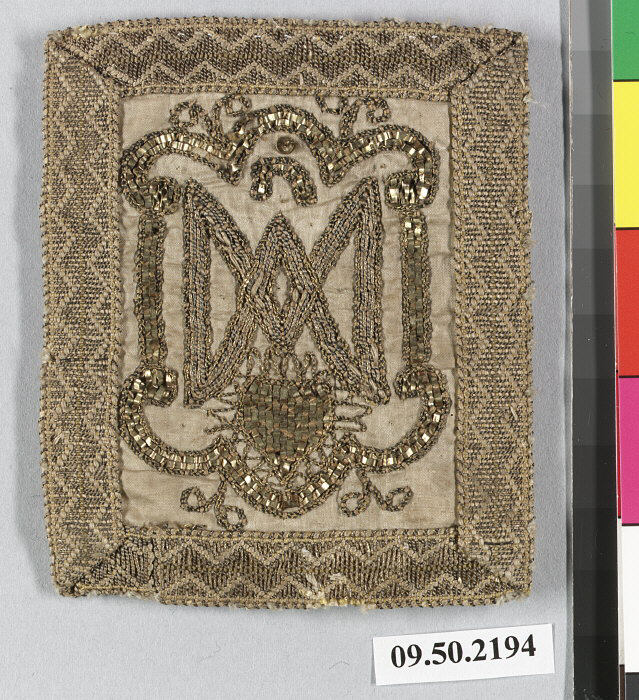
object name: scapular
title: Scapular (?) (one of a pair)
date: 1701-1800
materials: metal thread, silk